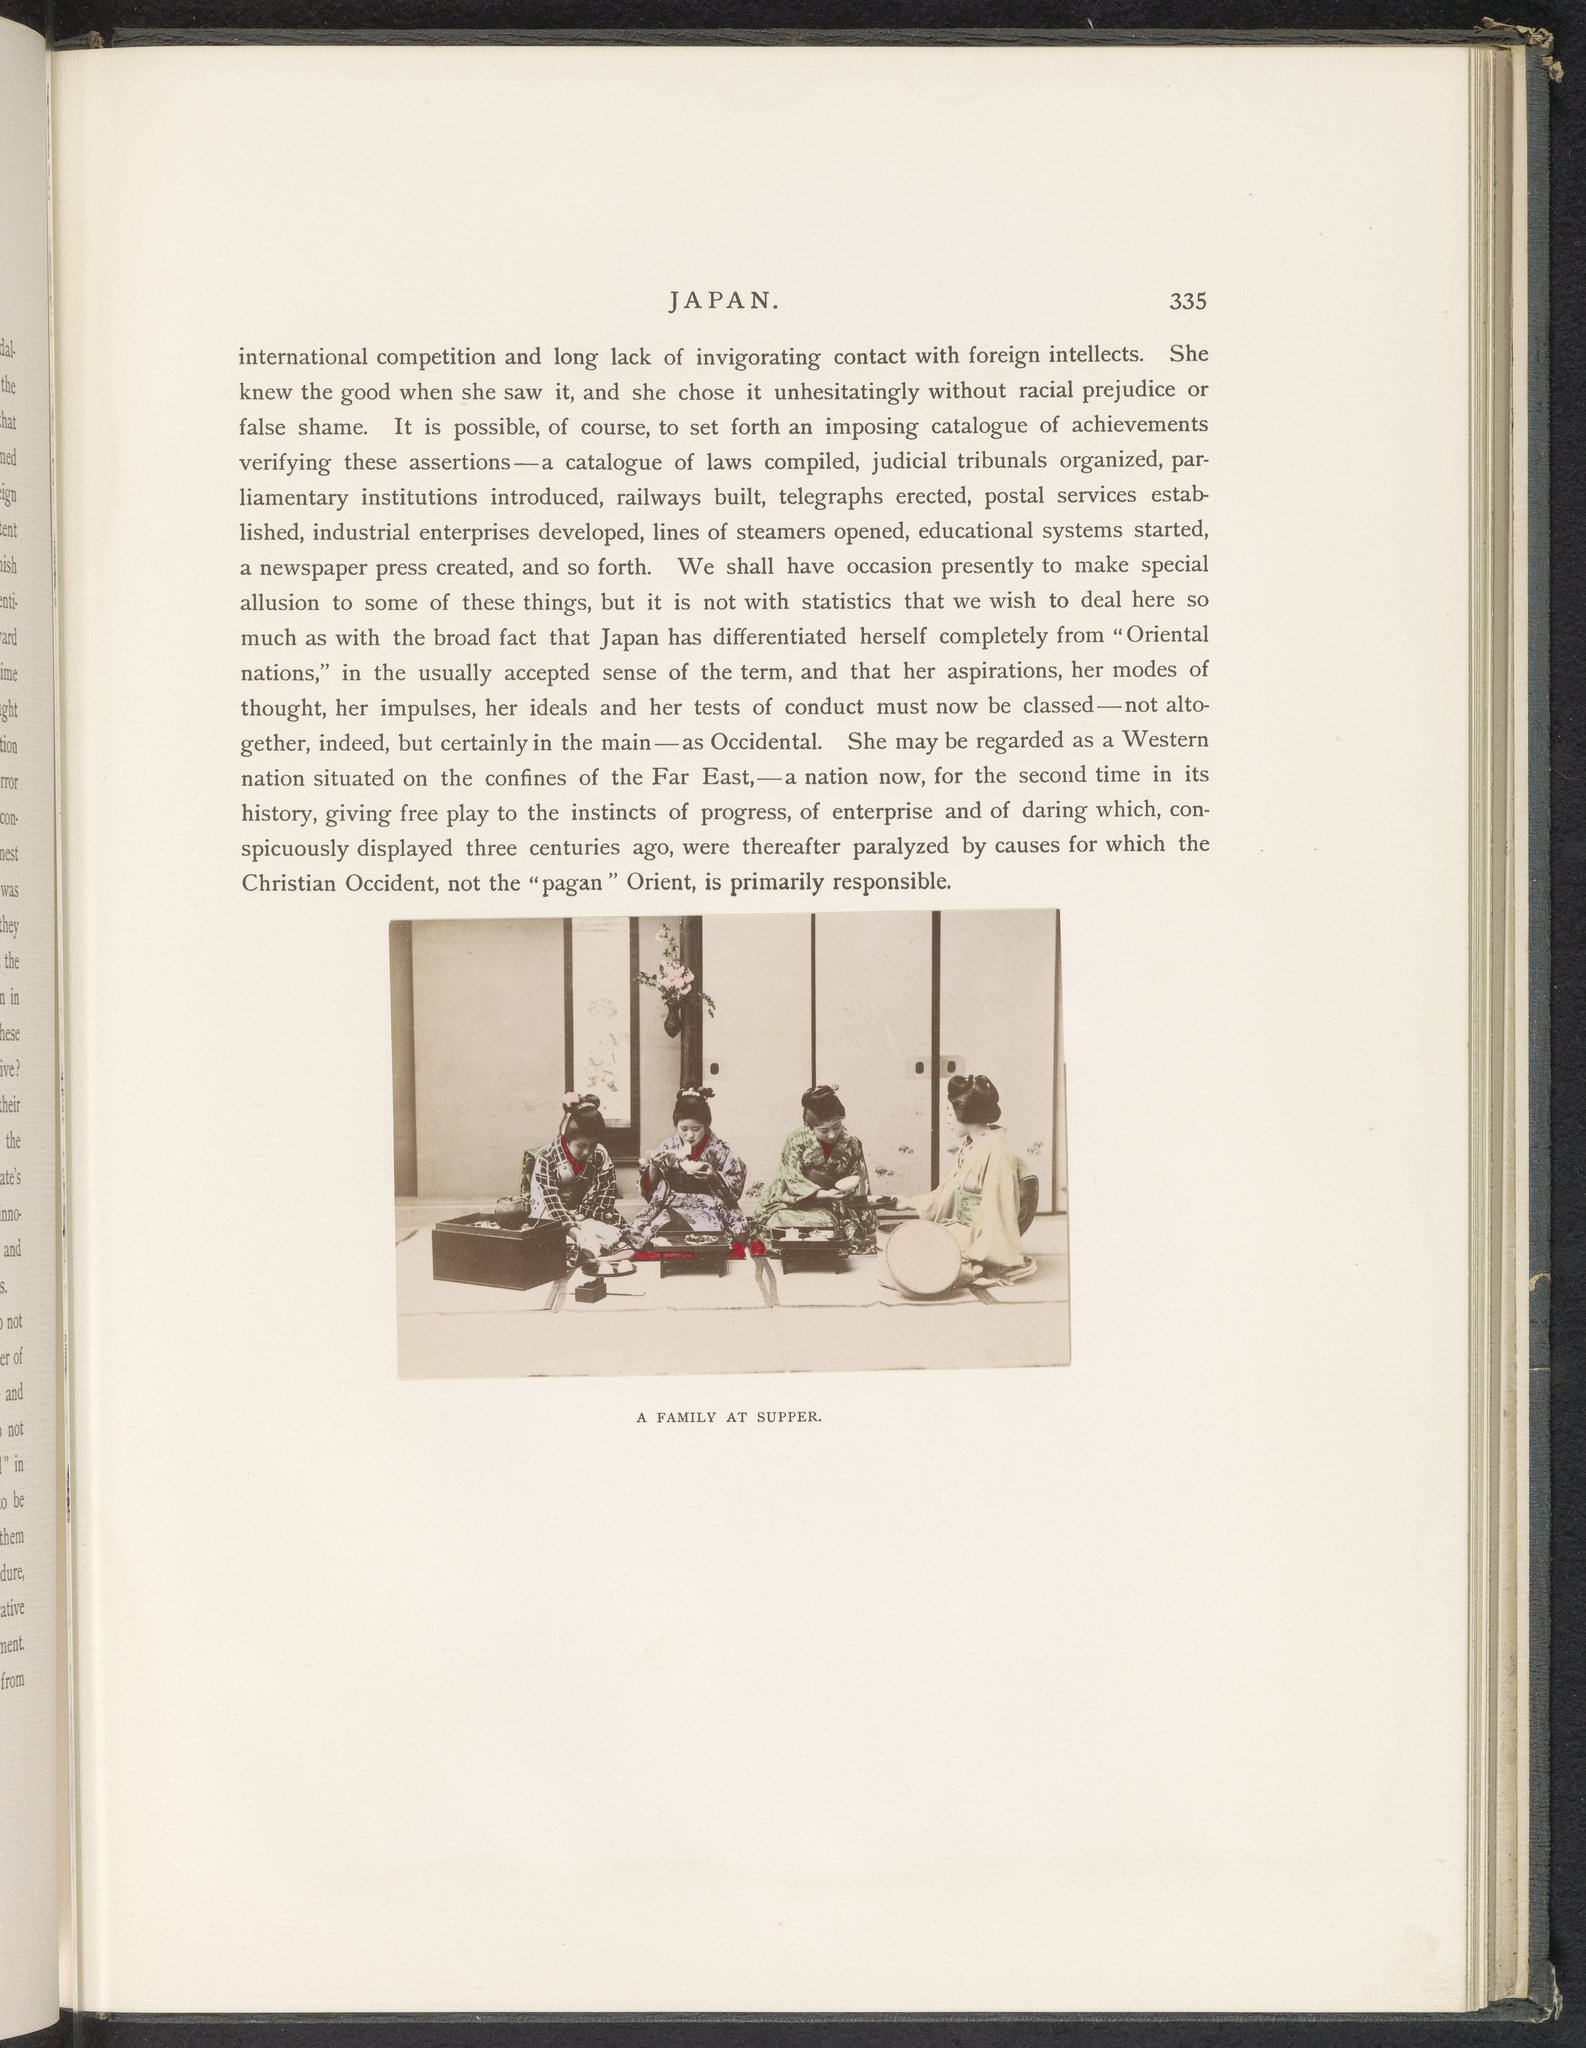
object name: photograph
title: A family at supper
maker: Anonymous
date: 1887-1897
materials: photographic support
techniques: albumen print, hand coloring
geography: japan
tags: (late) supper, interior ~ representation of a building, sitting on the ground - aa - female human figure